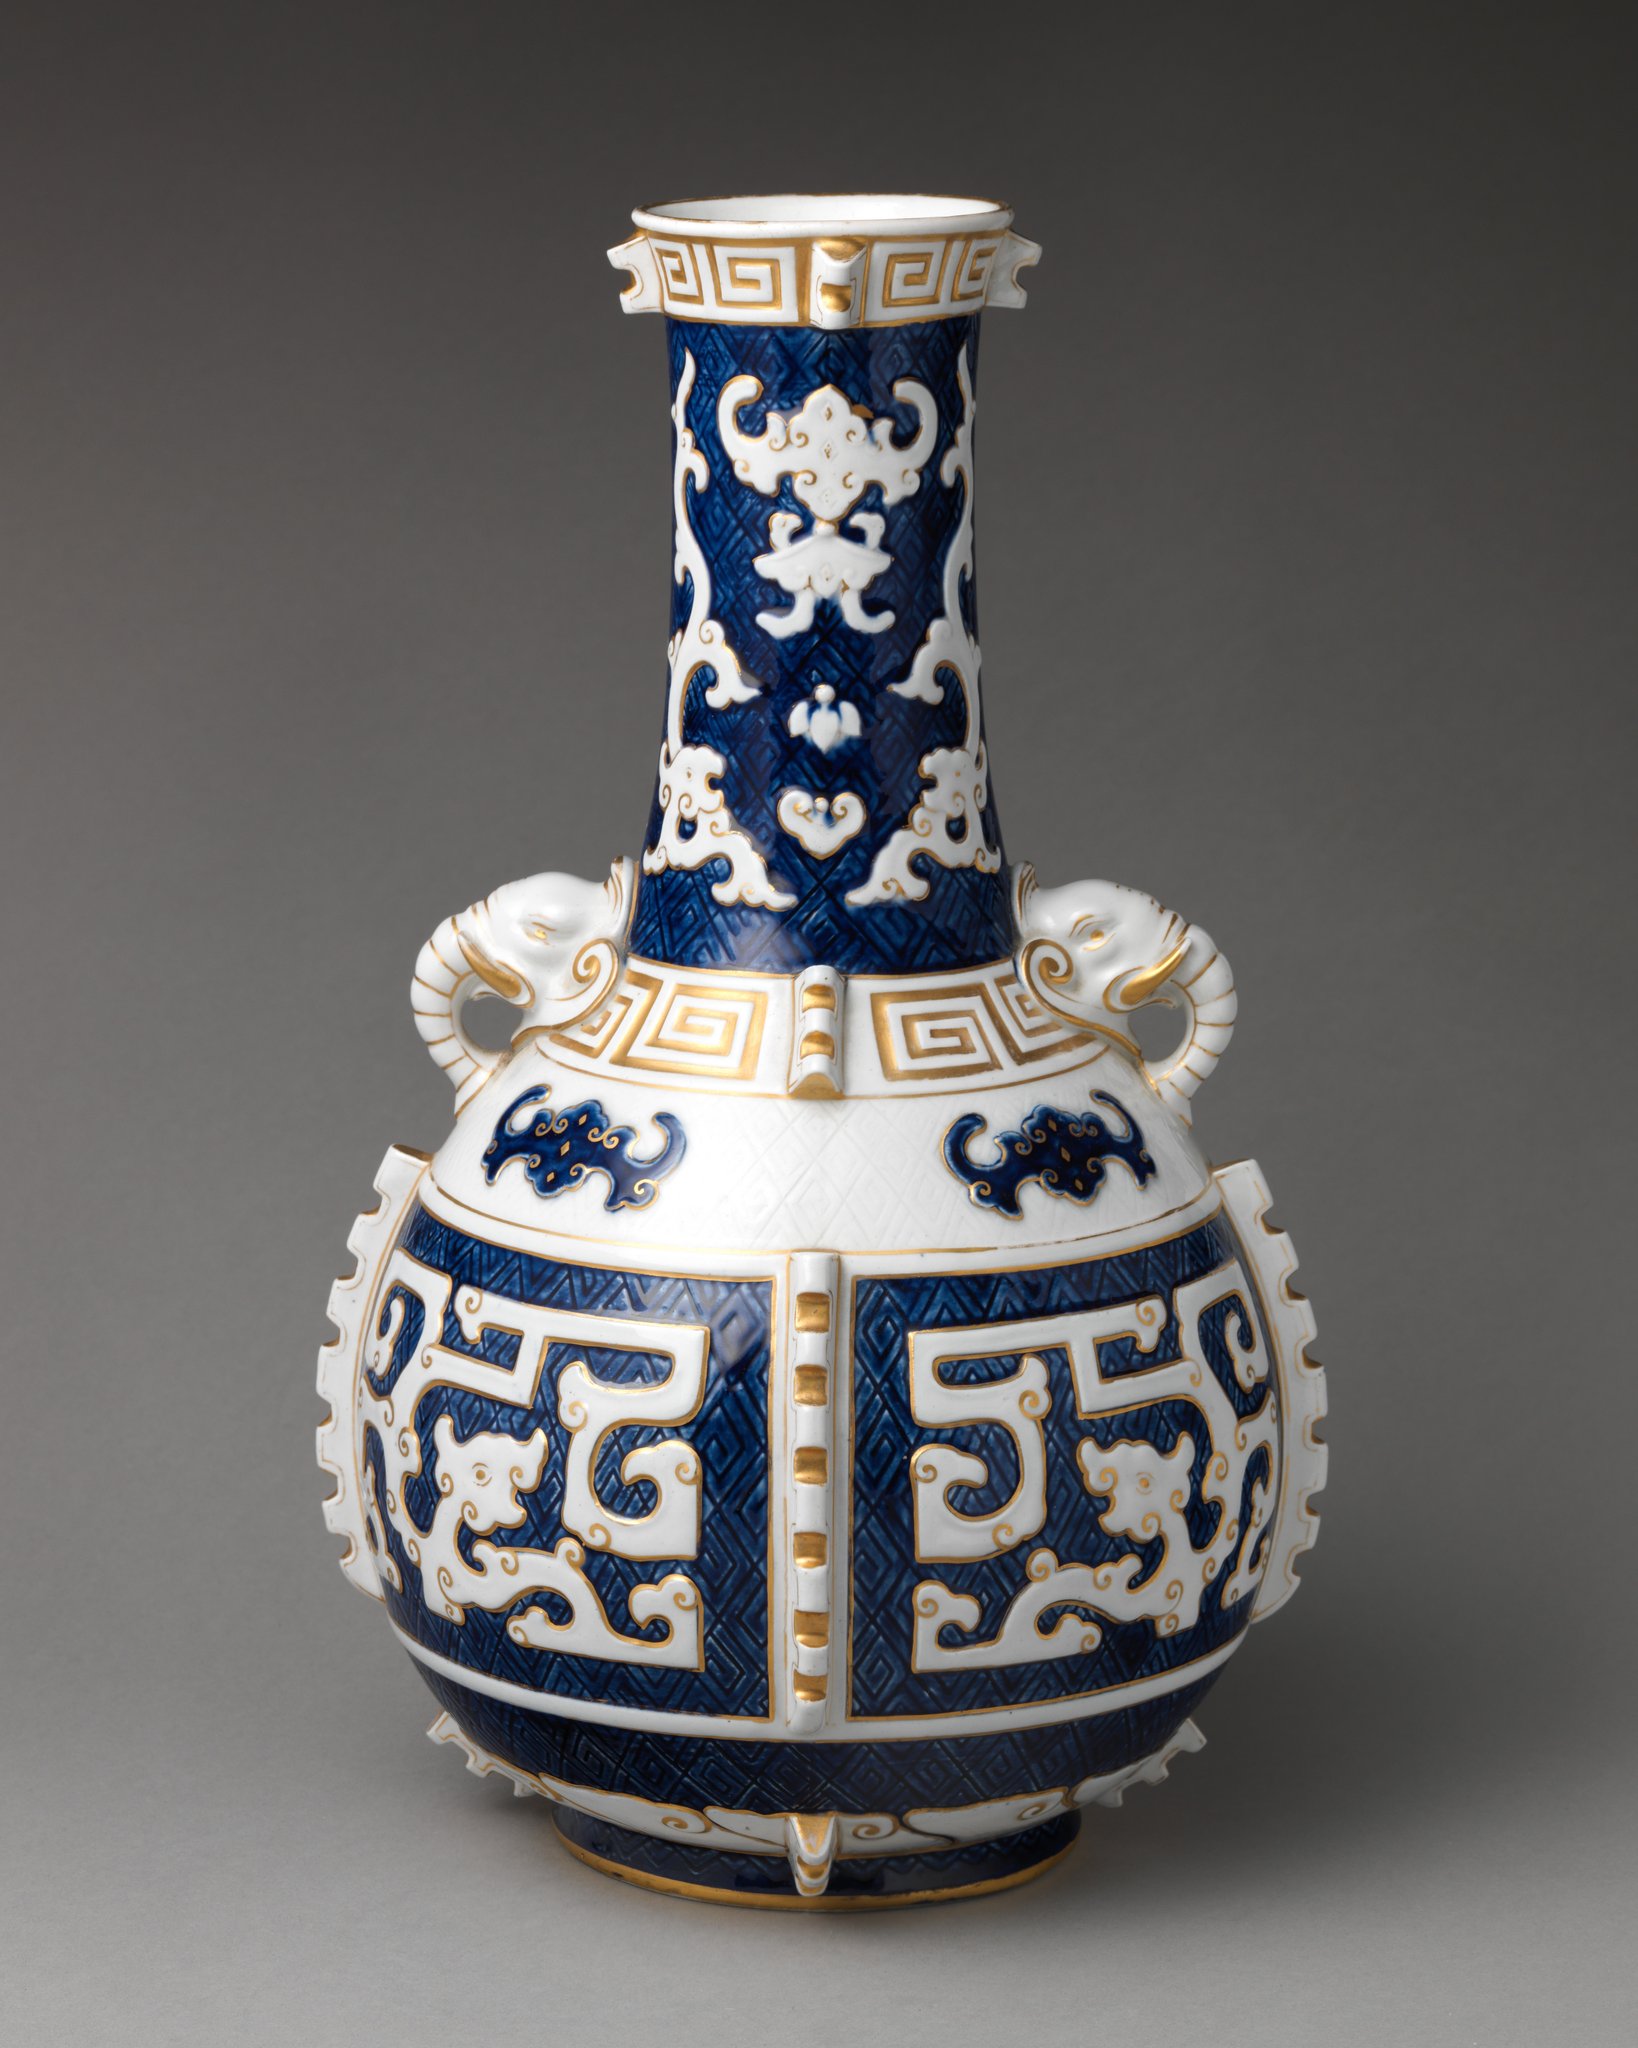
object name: vase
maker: worcester factory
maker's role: maker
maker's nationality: british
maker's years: 1751-2008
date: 1875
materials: earthenware